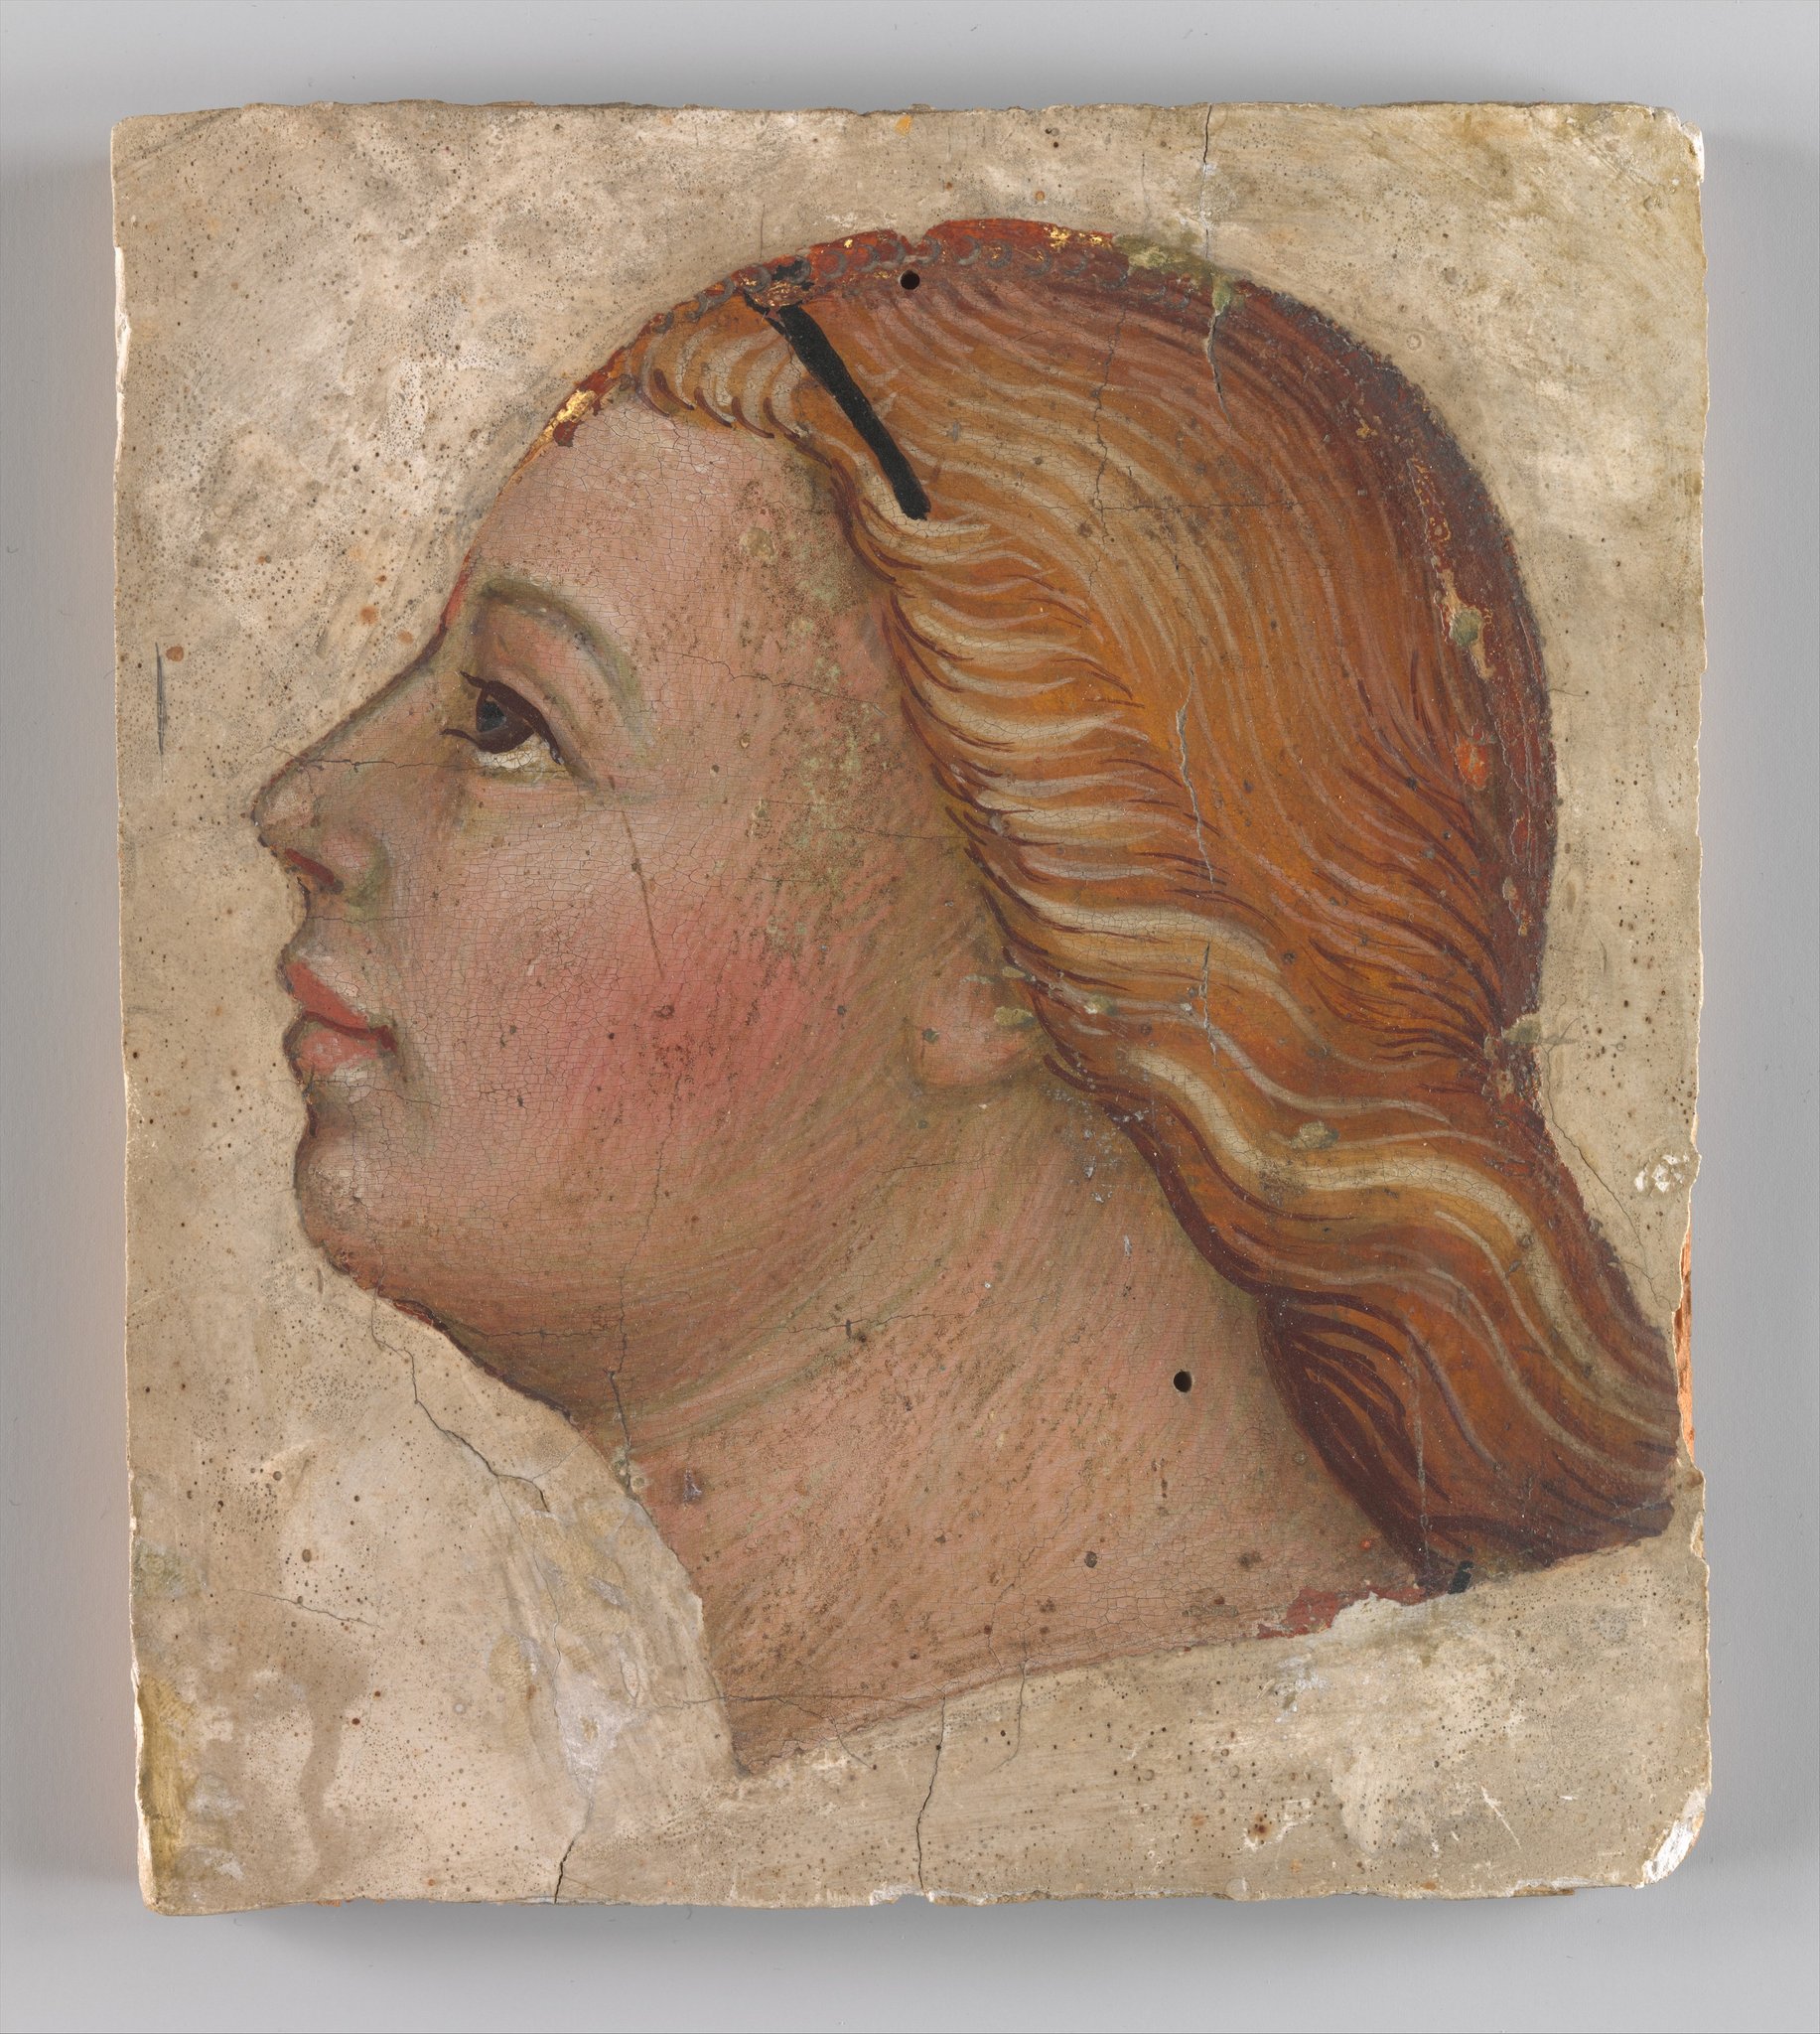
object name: painting fragment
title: Head of an Angel in Left Profile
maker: taddeo di bartolo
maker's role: artist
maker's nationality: italian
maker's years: 1362-1422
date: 1397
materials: paint, wood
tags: heads,profiles,angels